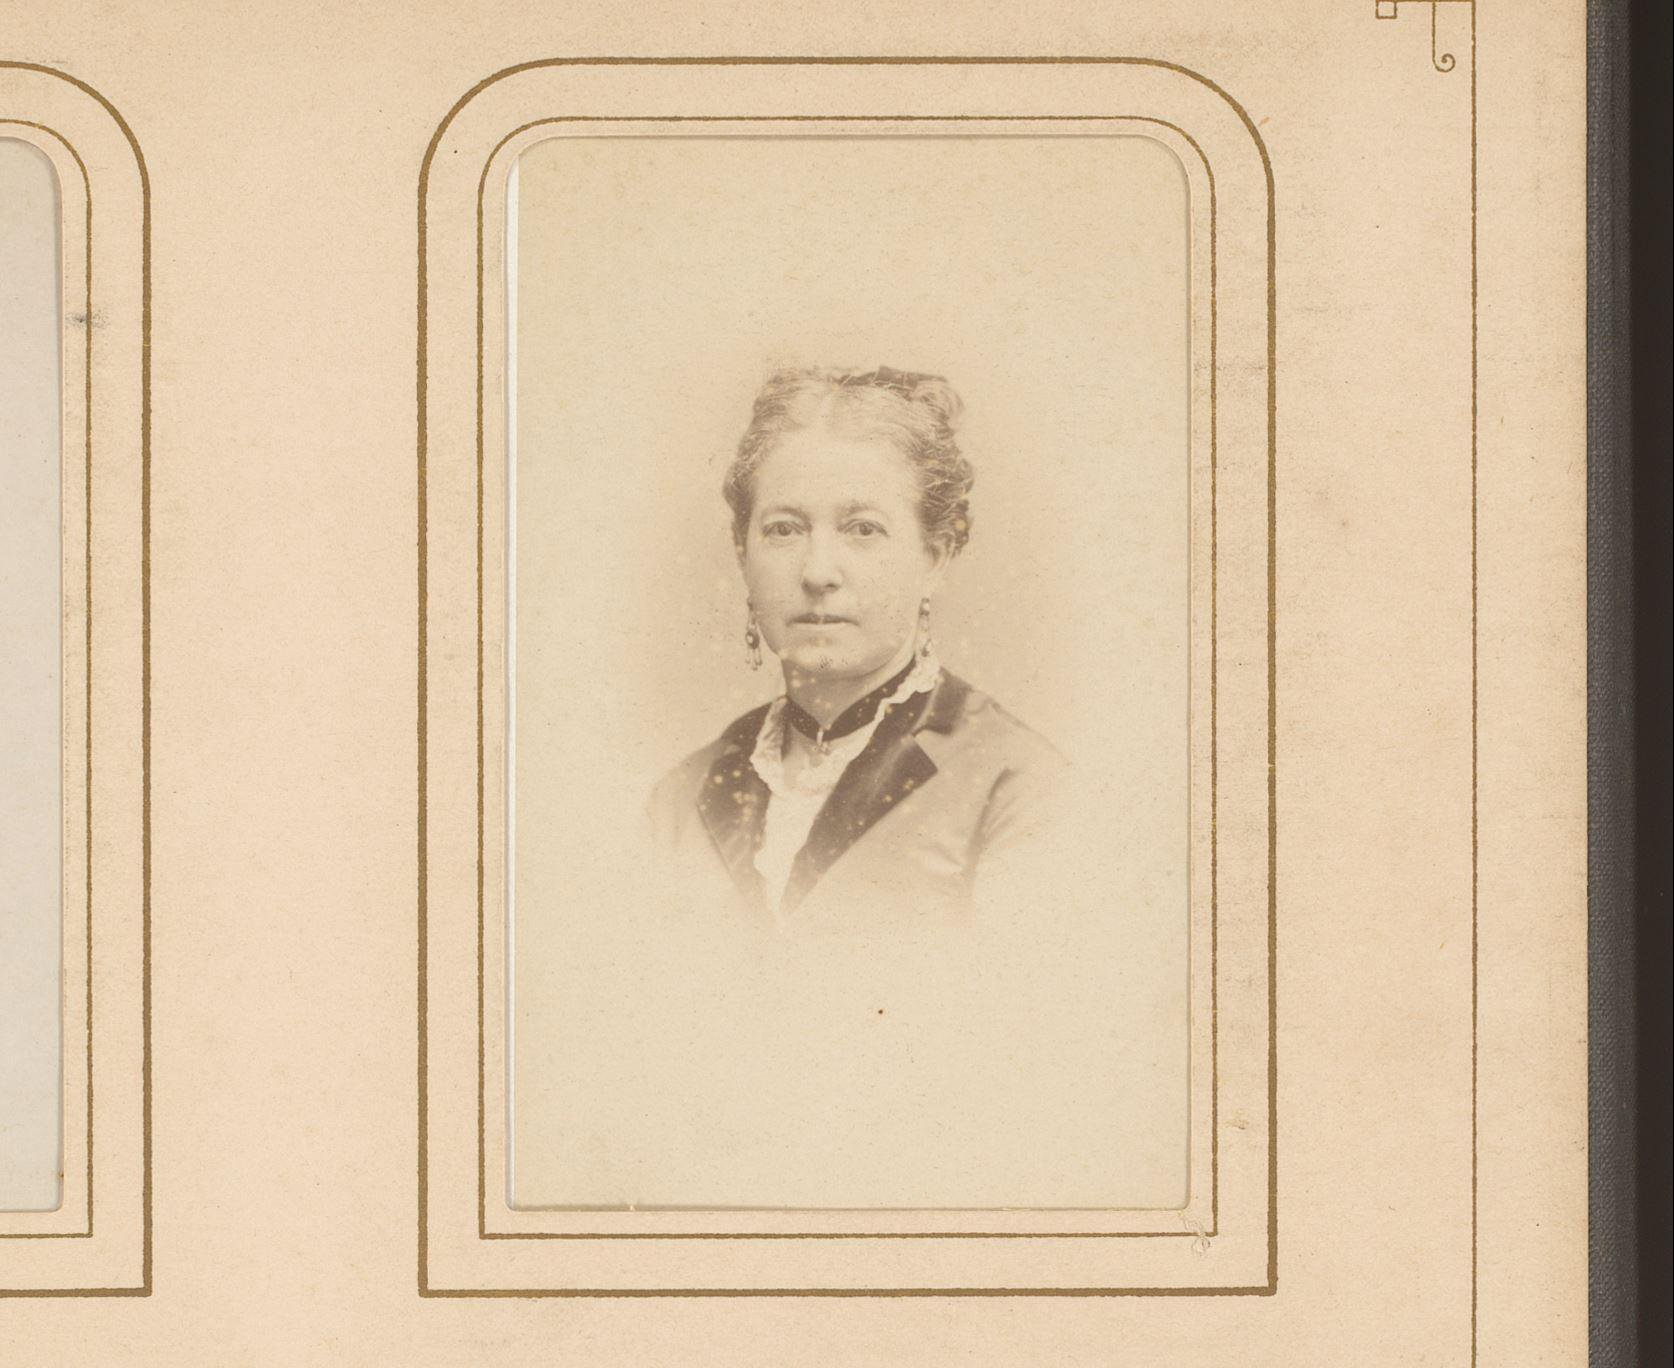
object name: carte de visite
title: Portret van een vrouw met oorbellen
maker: a. dupont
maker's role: fotograaf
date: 1878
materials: cardboard, photographic support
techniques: albumen print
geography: brussels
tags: historical persons - bb - woman, ear-rings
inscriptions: inscription: ‘A. Dupont - 57, Rue de la Loi/ BRUXELLES’